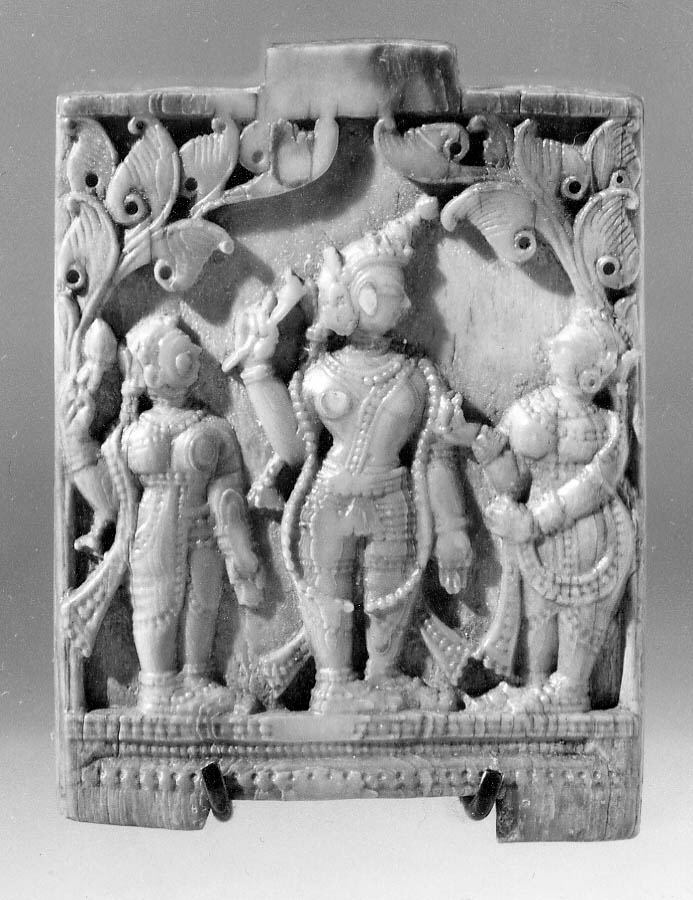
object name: plaque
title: Plaque with Krishna and Gopis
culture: indian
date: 1701-1800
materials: ivory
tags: krishna,hinduism